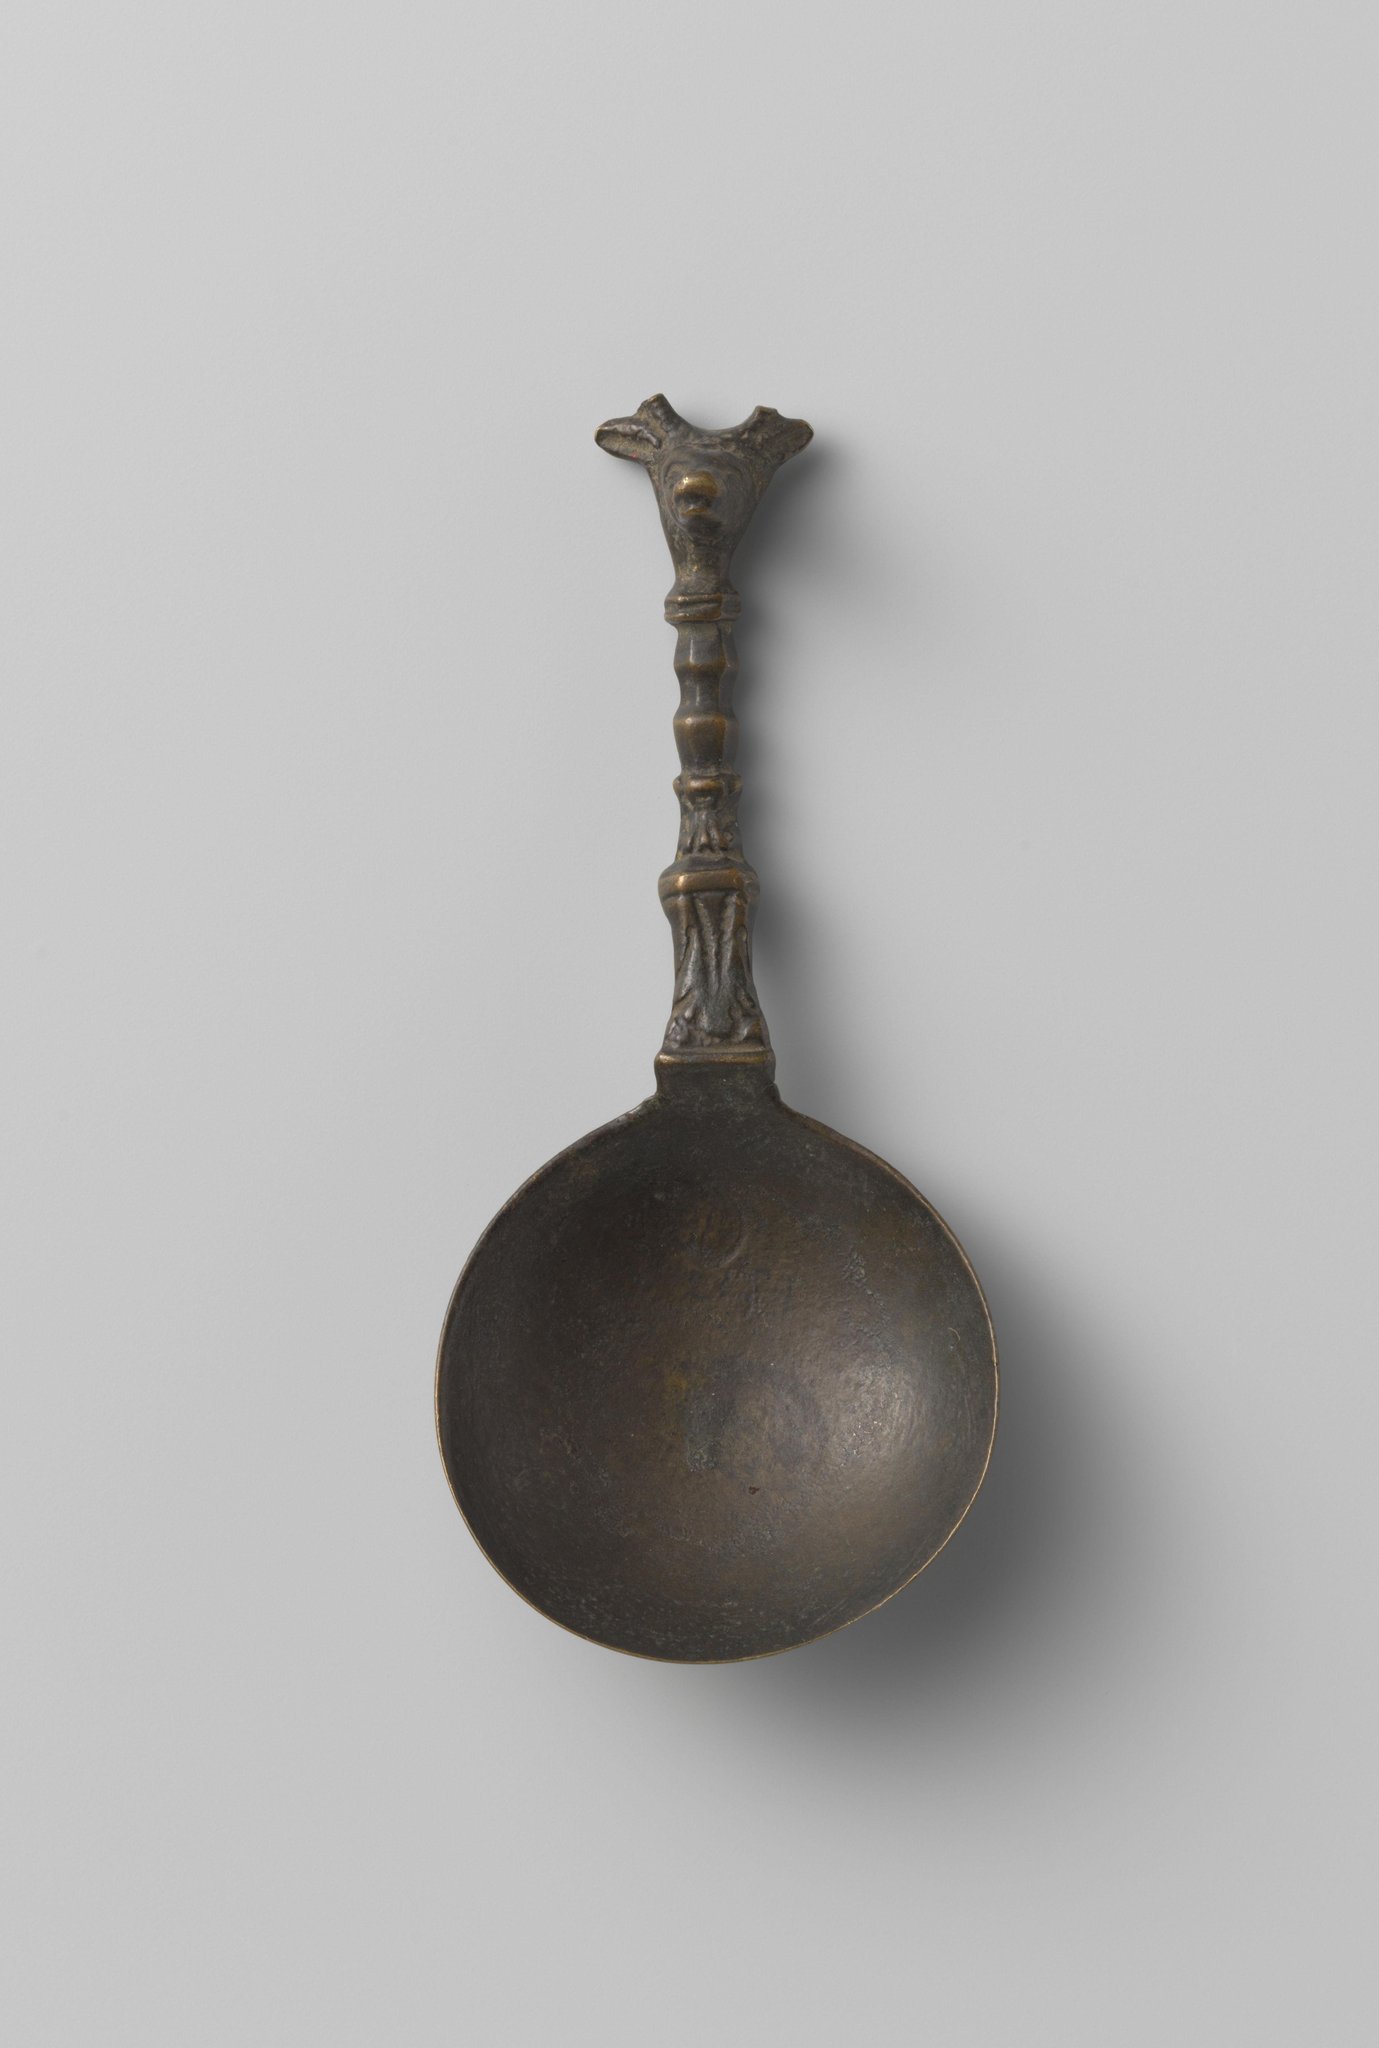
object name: spoon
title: Lepel waarvan de steel bekroond wordt door een hertekop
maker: Anonymous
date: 1500-1700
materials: brass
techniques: casting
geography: europe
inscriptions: quality mark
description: Spoon. Bronze. Italy, c. 1600.